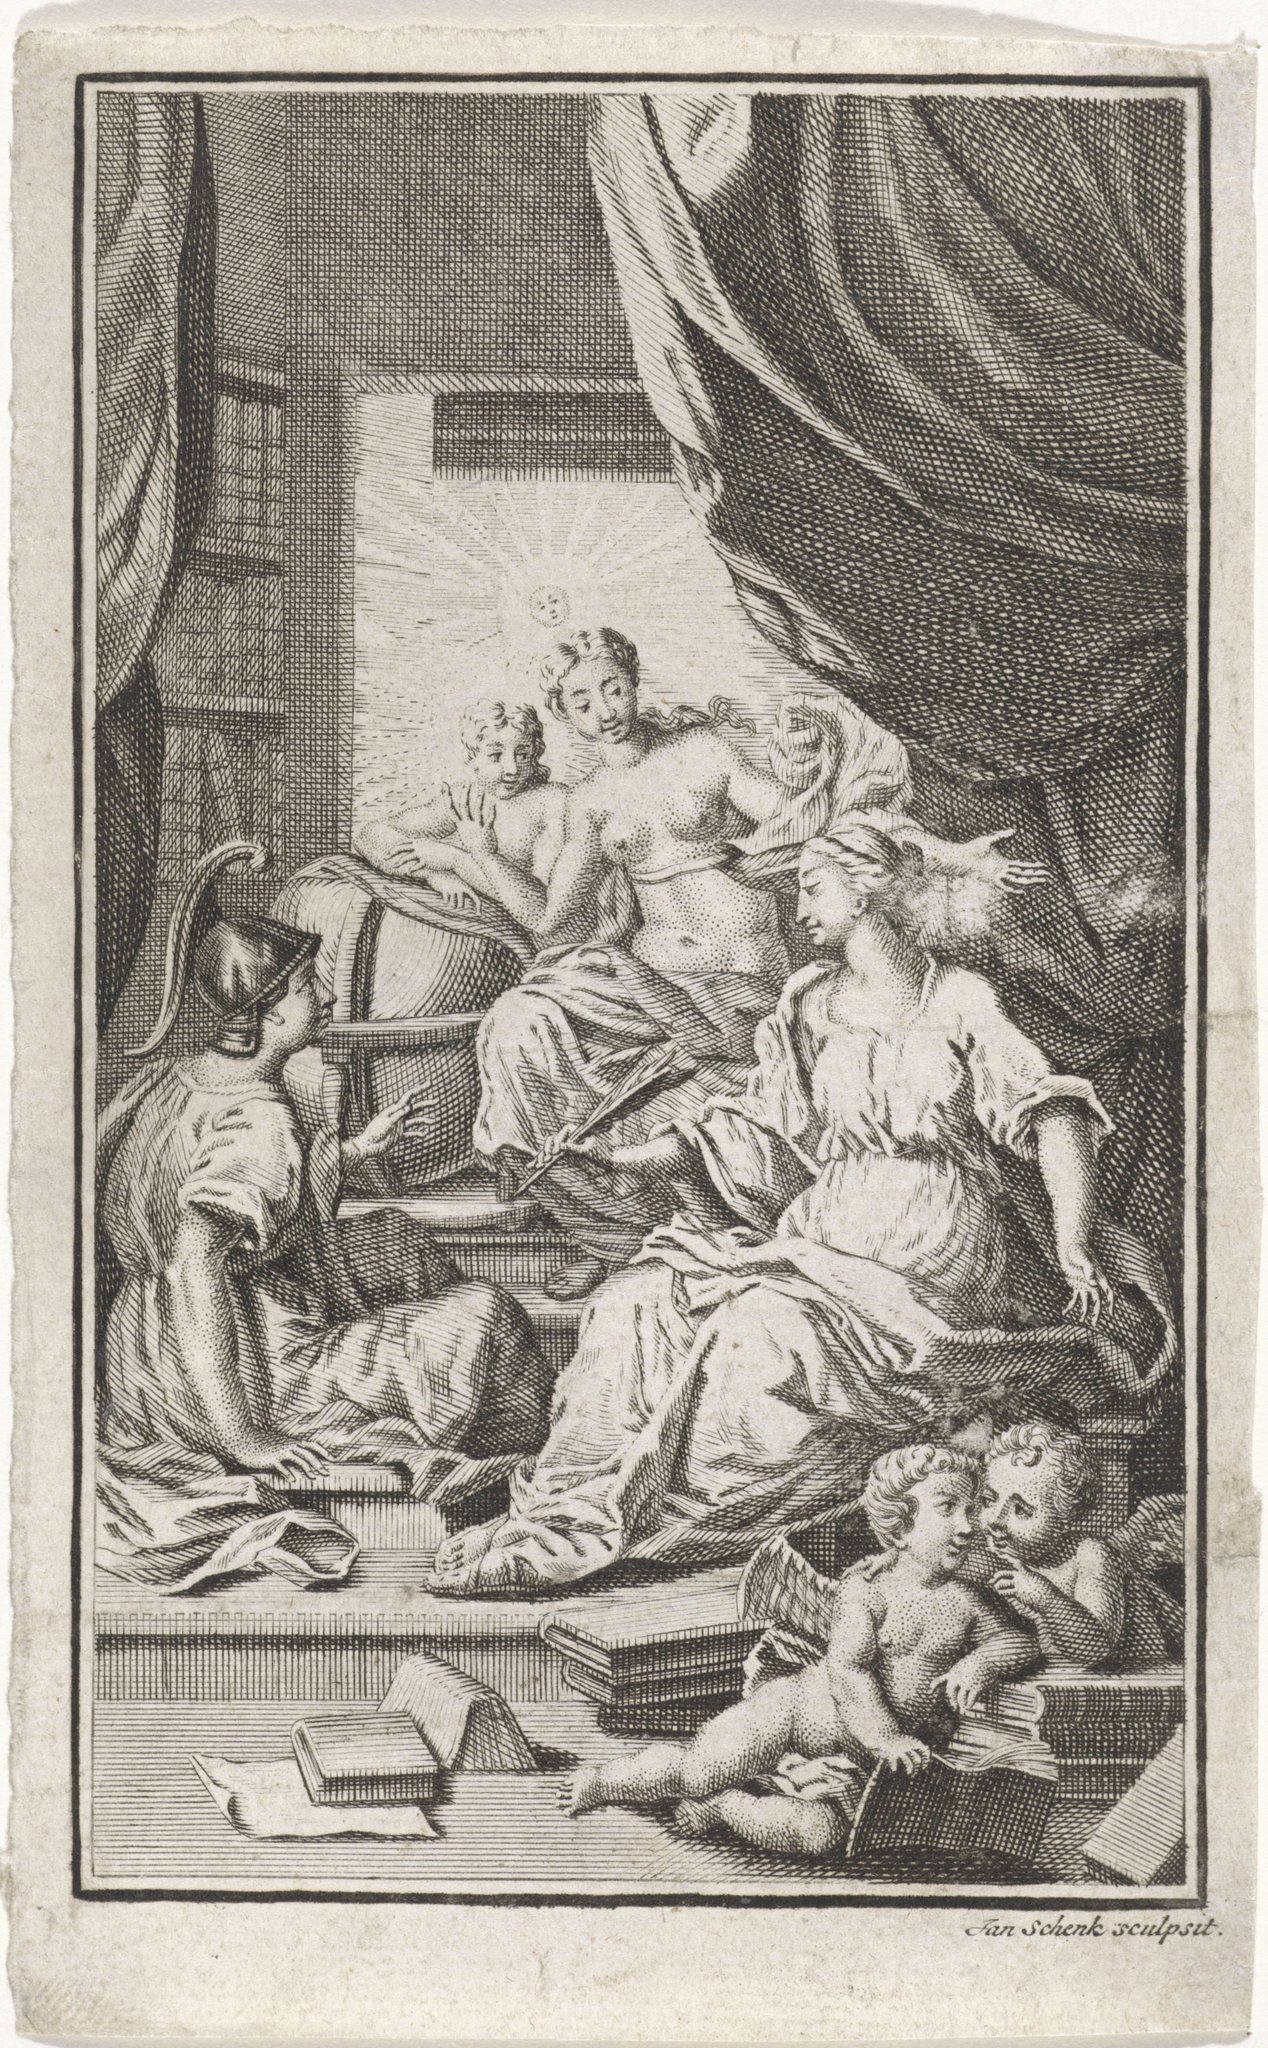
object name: print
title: Allegorische voorstelling met Minerva in een studeerkamer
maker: jan schenk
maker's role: draughtsman, print maker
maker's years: 1698-1752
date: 1713-1752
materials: paper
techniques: engraving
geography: amsterdam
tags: truth; 'verità' (ripa) (+ allegorical scene, i.e. two or more personifications involved in an action), literature (+ variant), study; 'studiolo'; library, specific aspects, allegorical aspects of minerva; minerva as patroness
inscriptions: collector's mark: Lugt 2228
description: In een studeerkamer zit Minerva tegenover de personificatie van de literatuur. Minerva draagt een helm en de Literatuur houdt een schrijfveer vast. Achter hen zit de Waarheid(?) bij een globe. Vooraan zitten twee putti tussen enkele boeken.